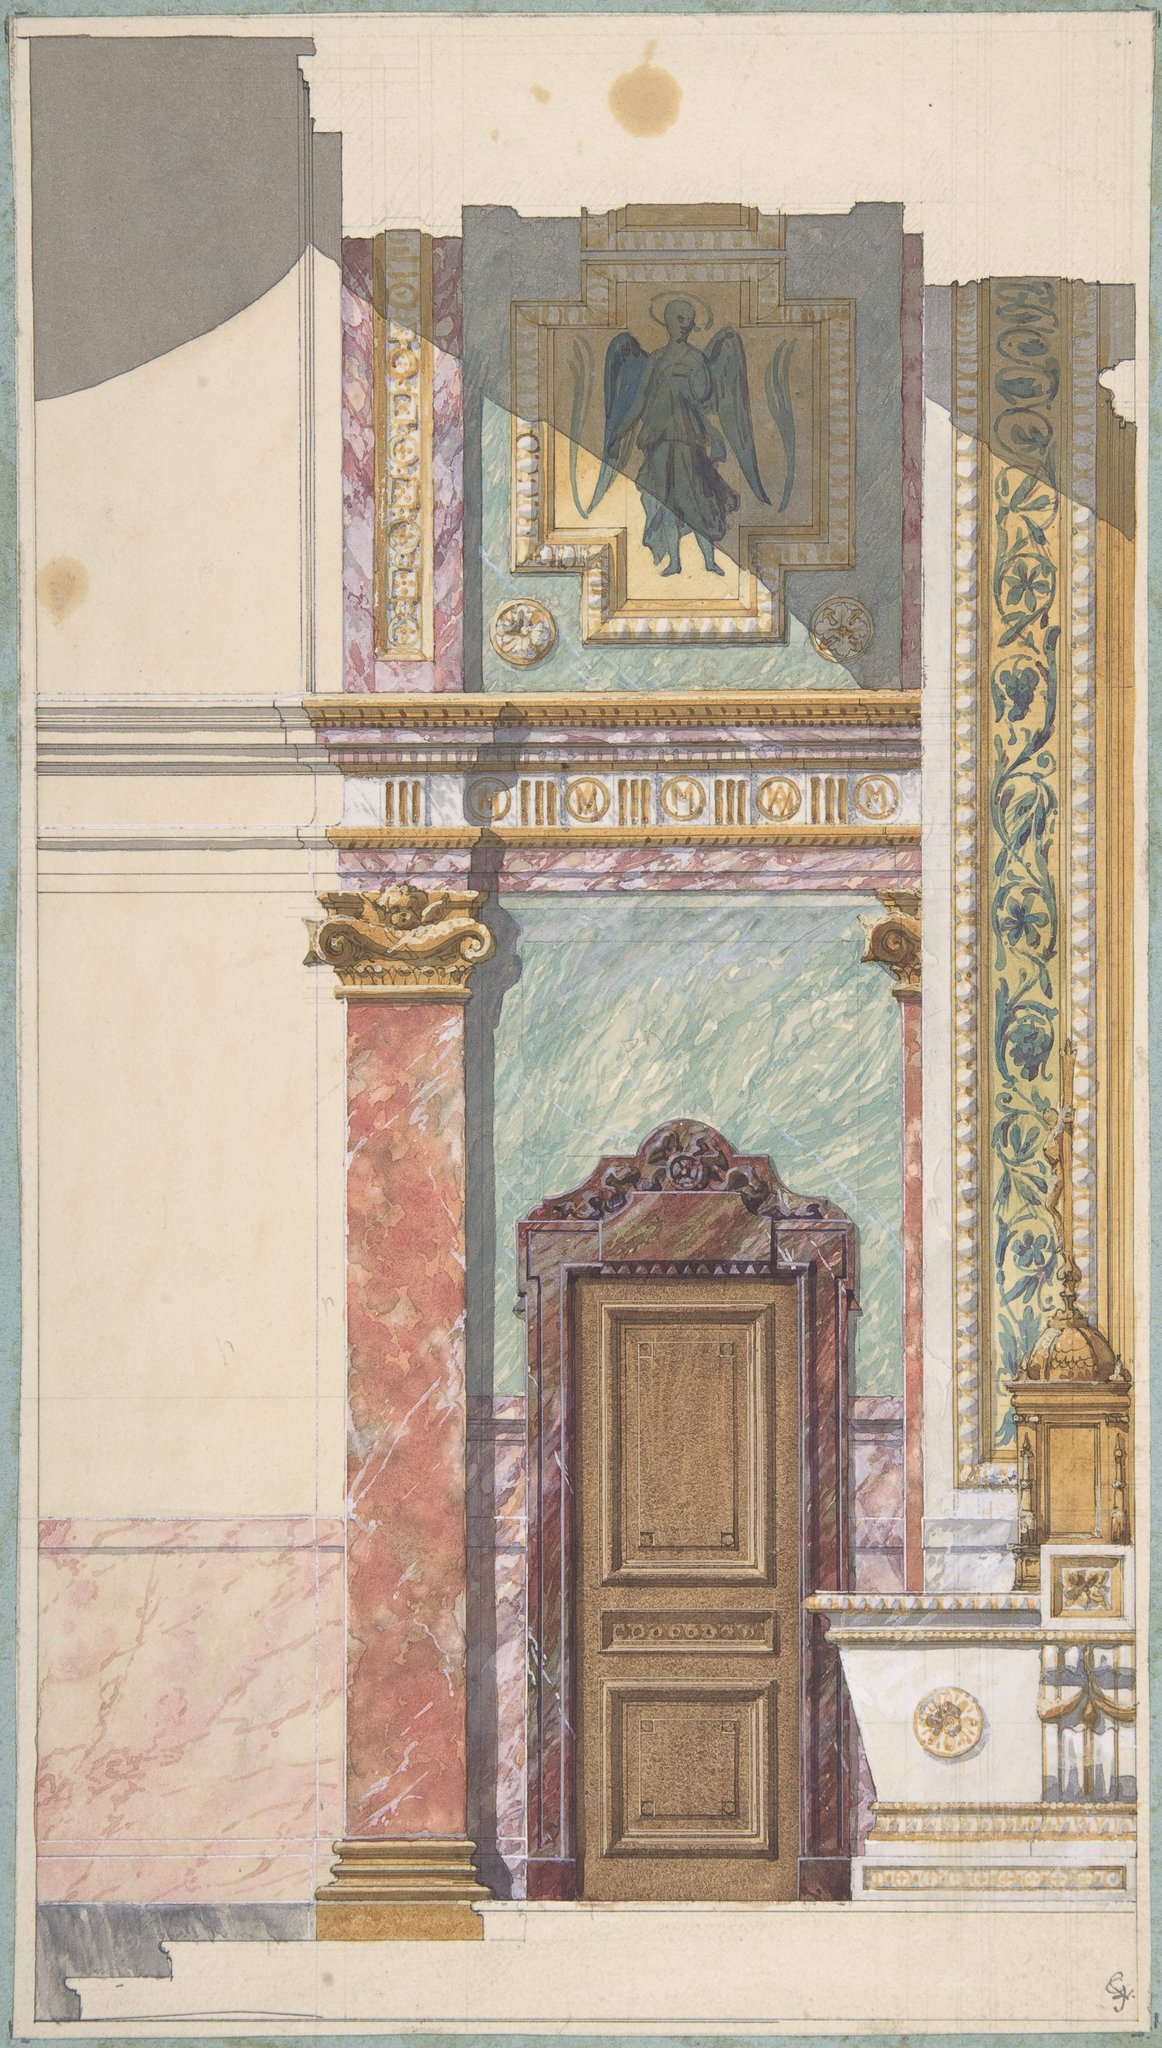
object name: drawing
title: Side View of Design for Altar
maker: jules-edmond-charles lachaise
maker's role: artist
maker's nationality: french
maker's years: 1897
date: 1851-1900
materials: watercolor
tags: altars,doors,angels